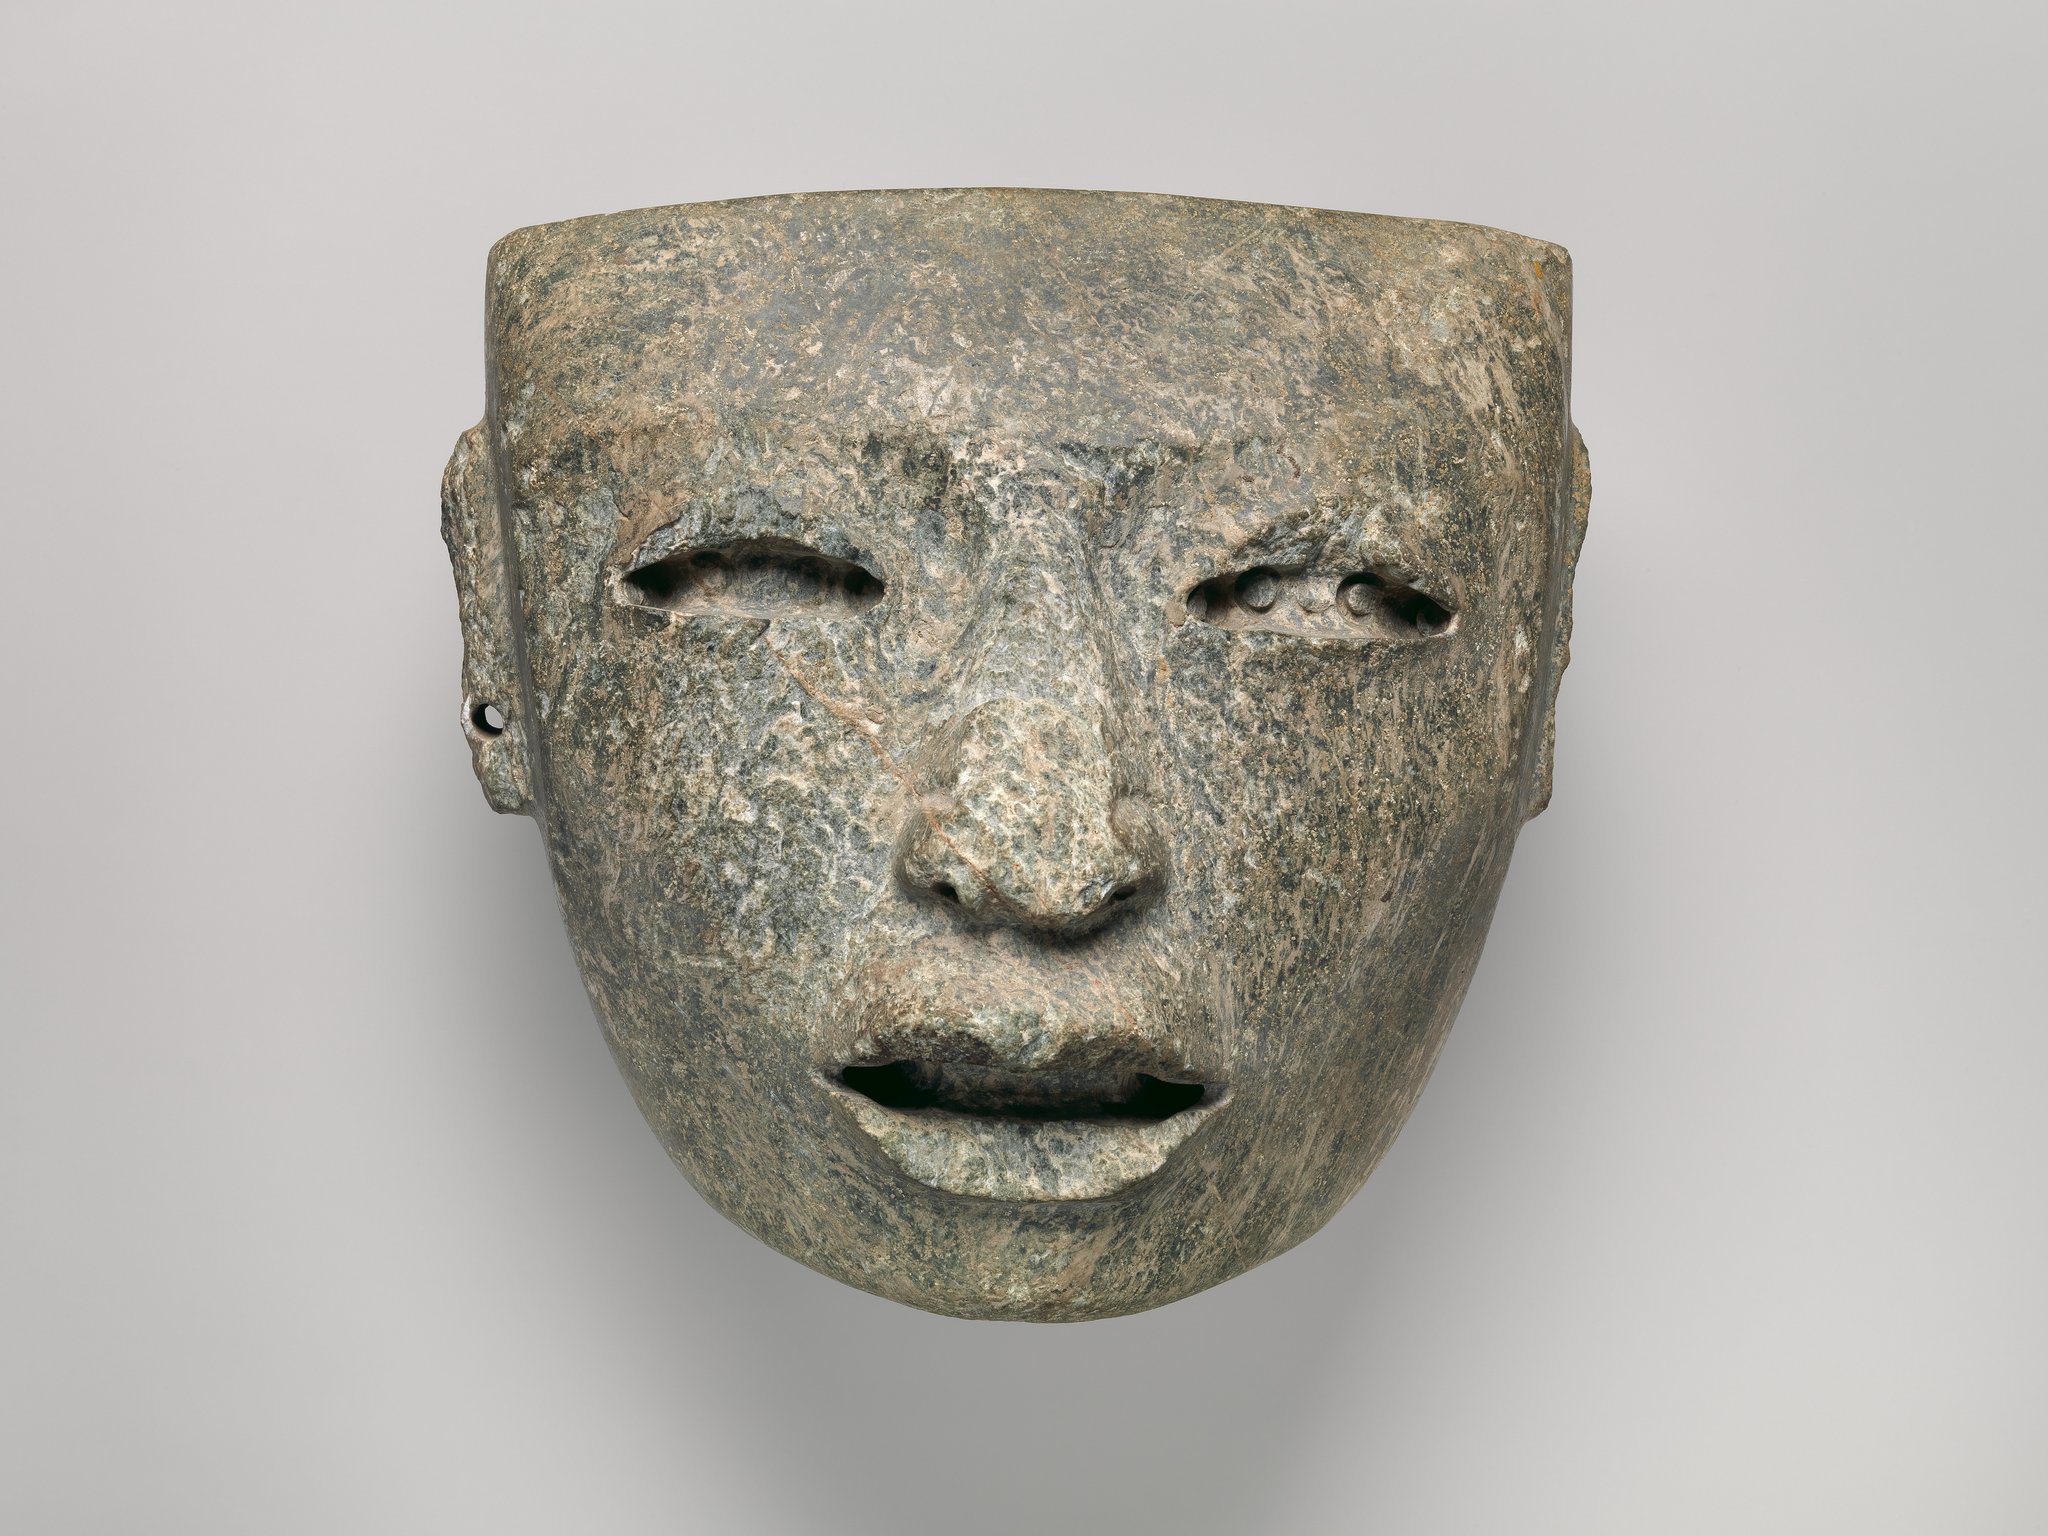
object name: mask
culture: teotihuacan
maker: teotihuacan artist(s)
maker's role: artist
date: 201-700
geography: mexico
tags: faces